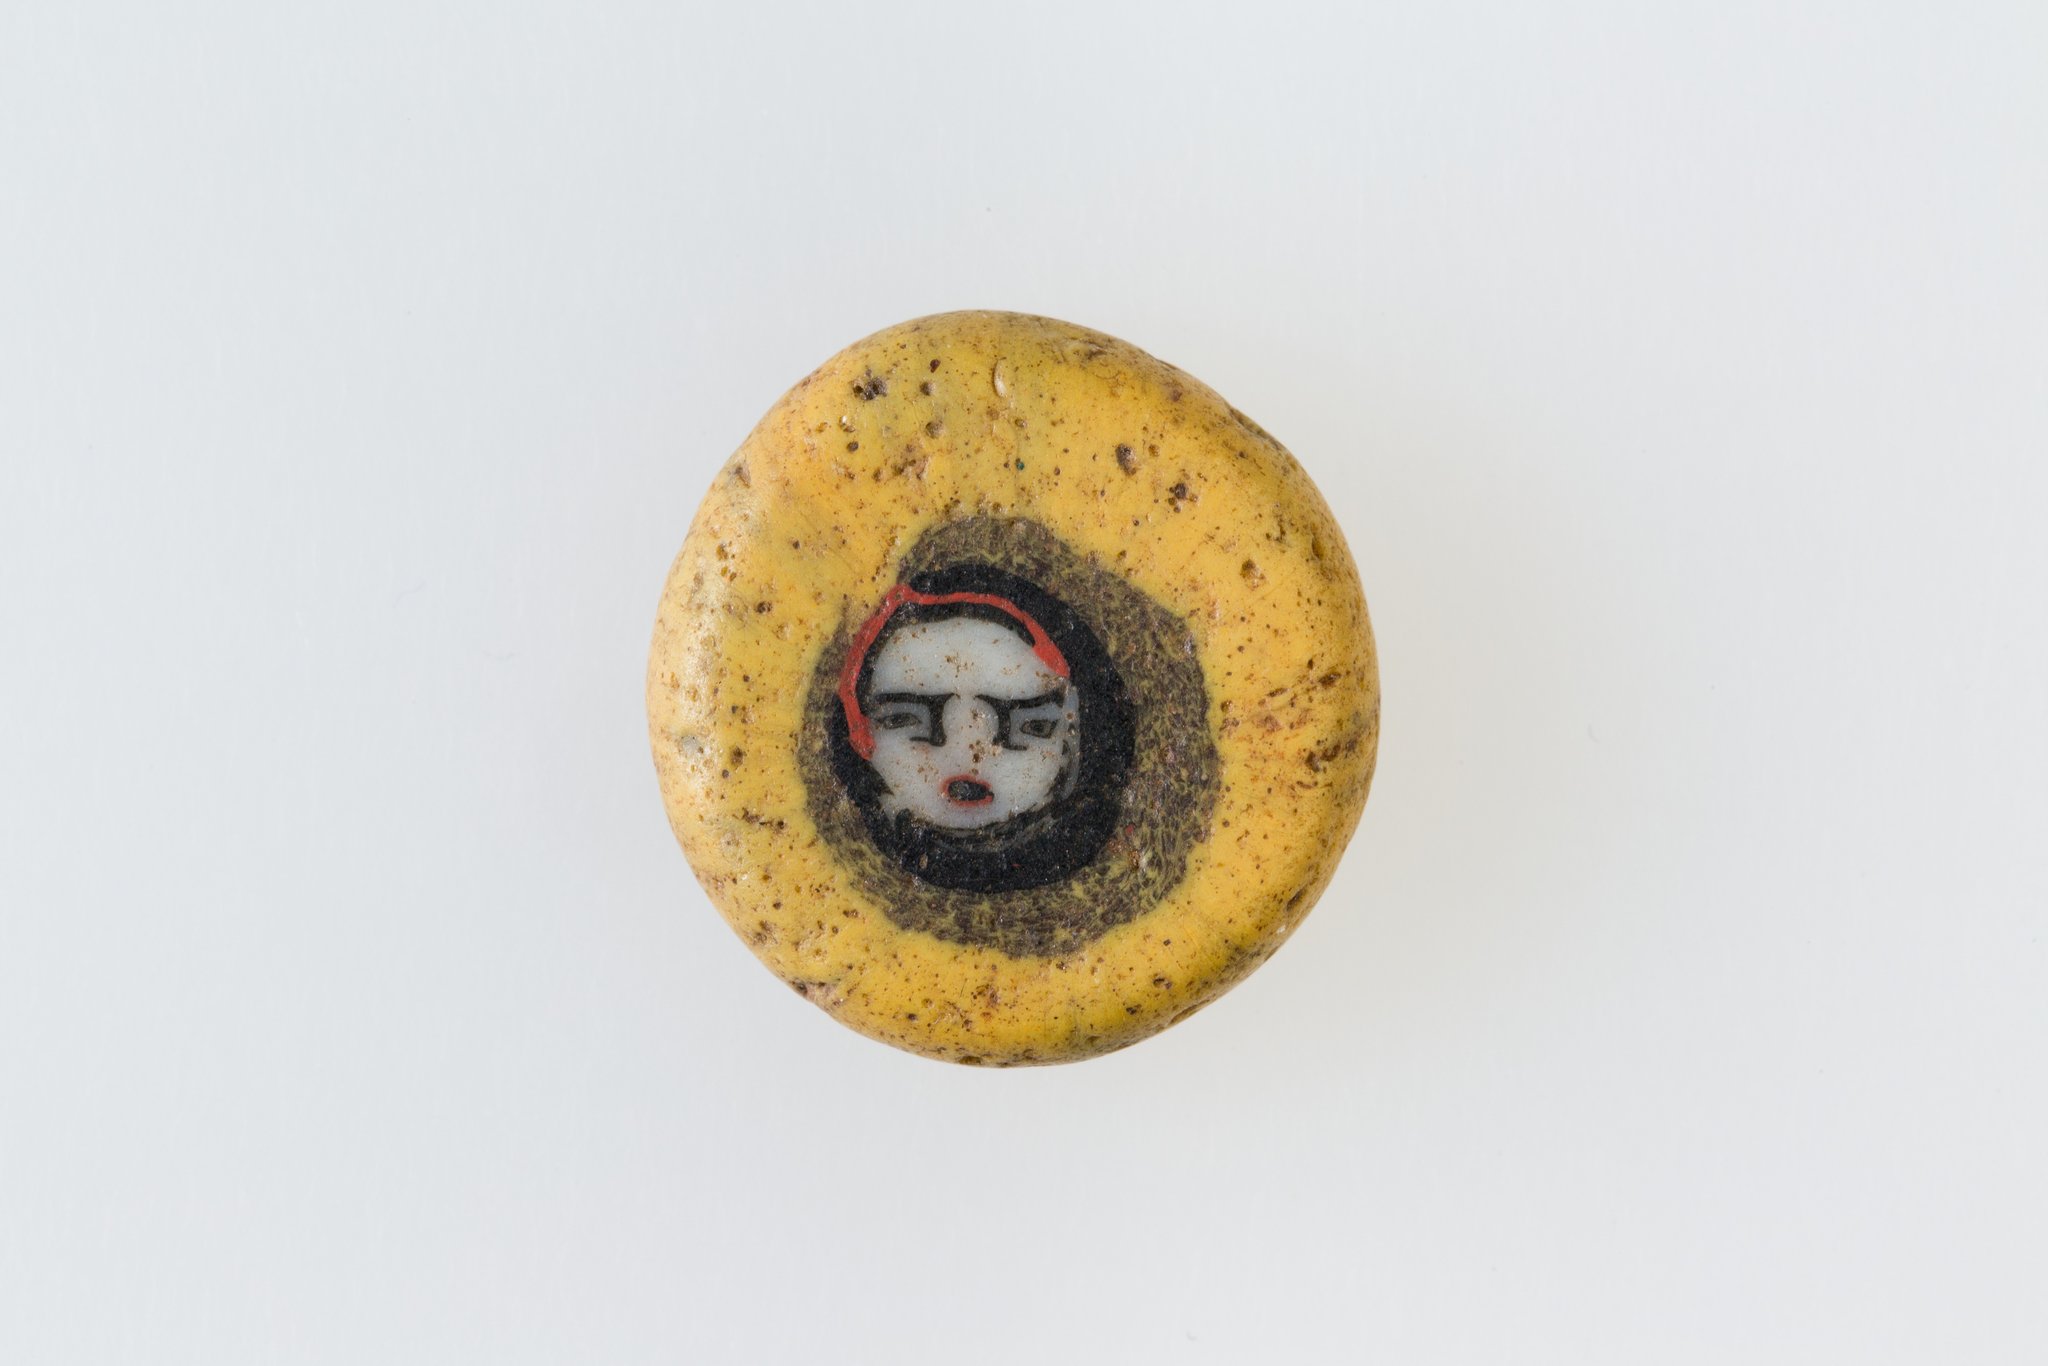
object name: inlay, face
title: Inlay / bead blank with face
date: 100 BCE-100 CE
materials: glass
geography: egypt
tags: faces